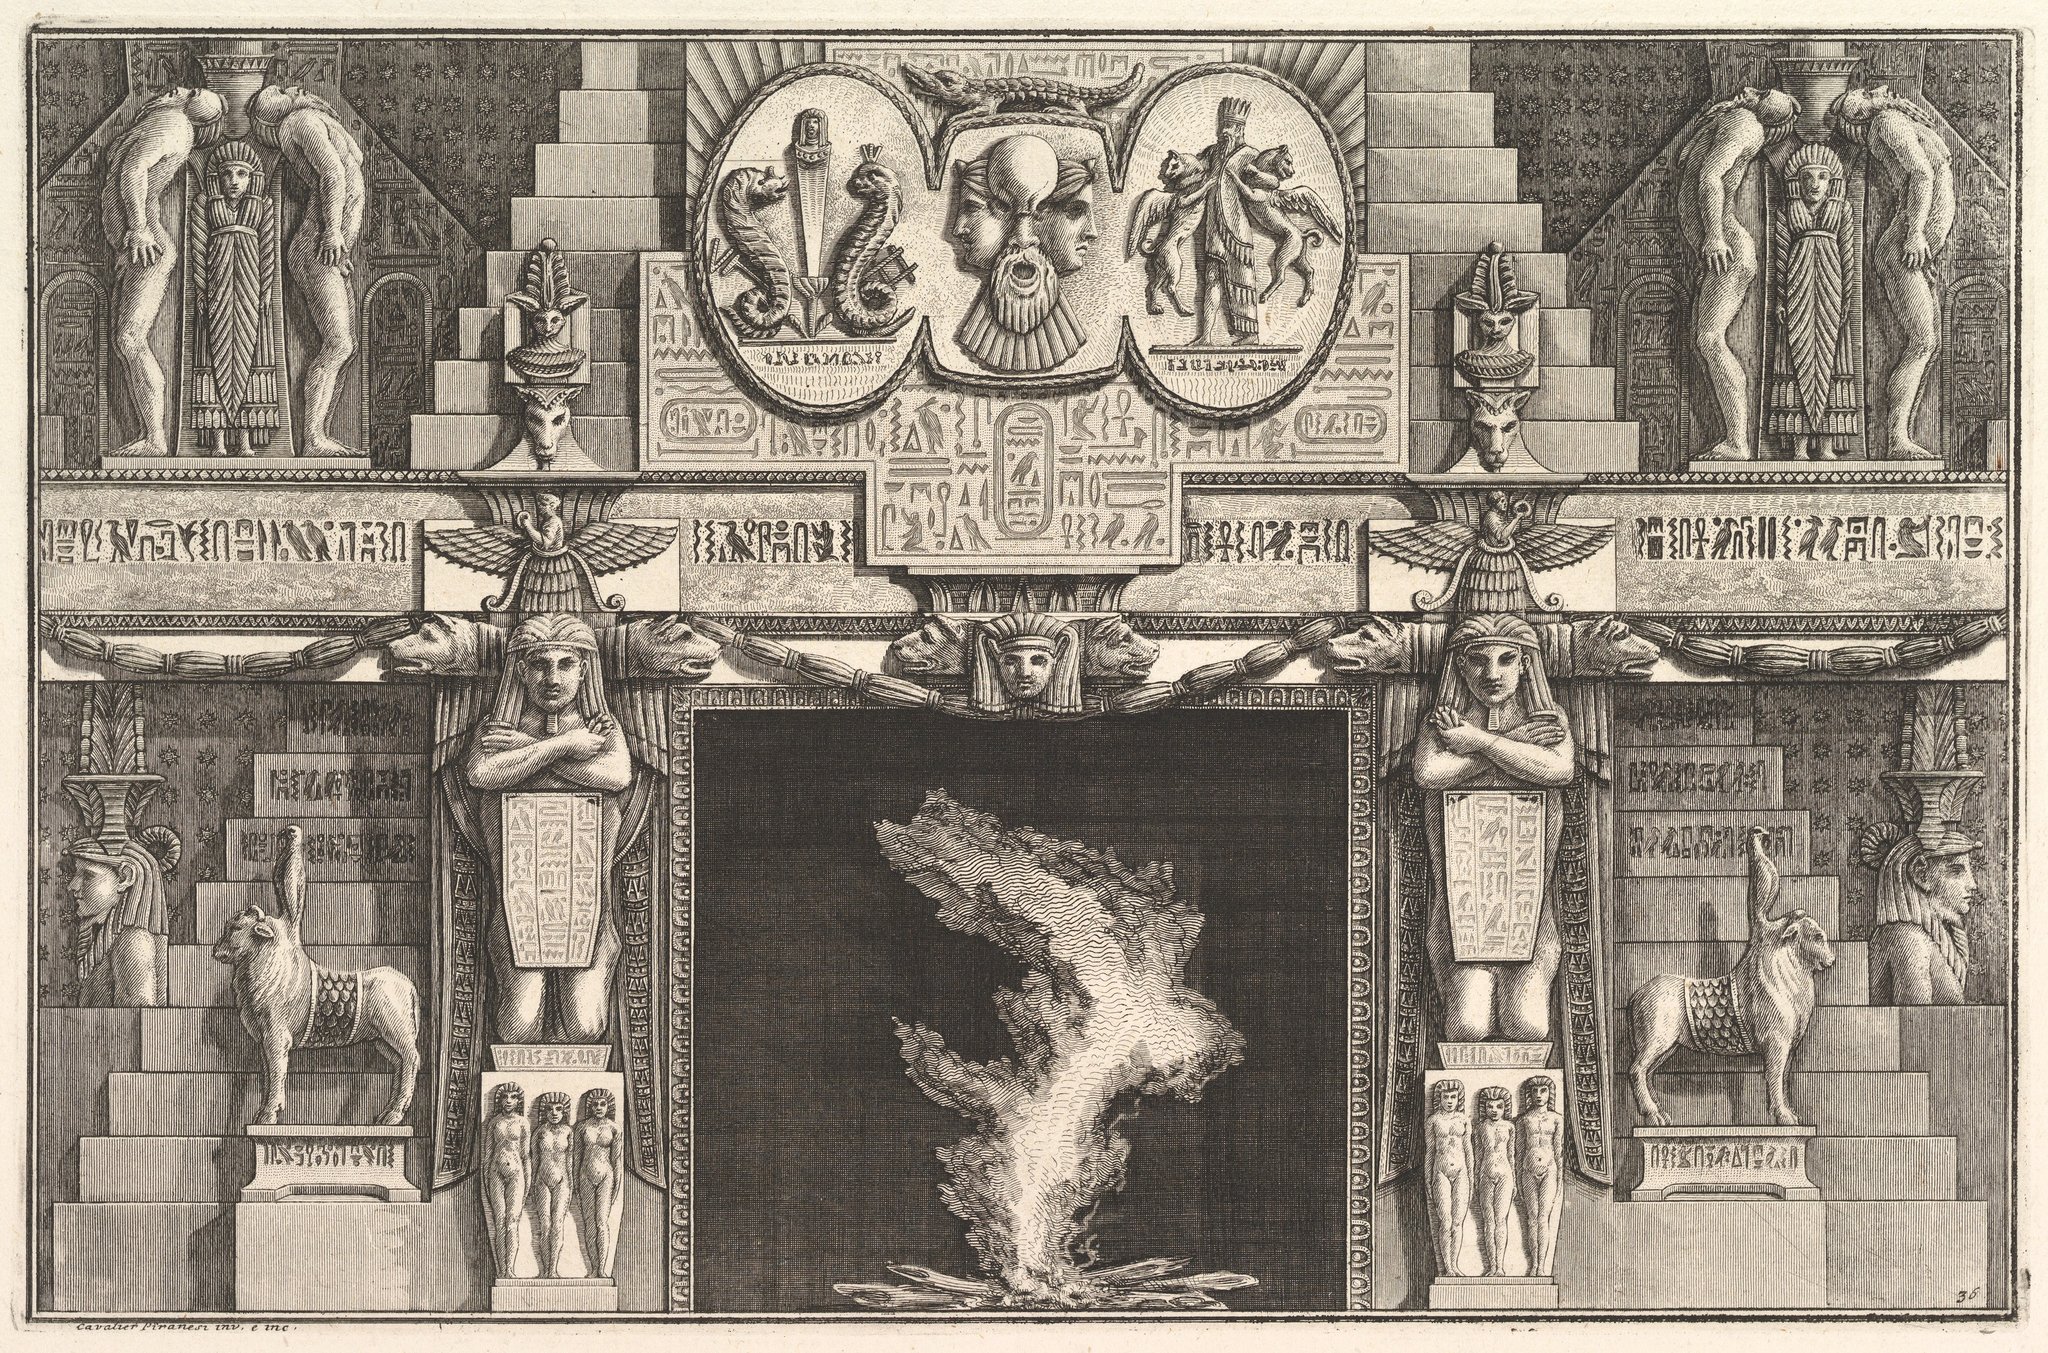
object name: print ornament architecture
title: Chimneypiece in the Egyptian style: Groups of three female nudes at the base of each jamb, surmounted by larger kneeling figures), from Diverse Maniere d'adornare i cammini ed ogni altra parte degli edifizi...(Different Ways of ornamenting chimneypieces and all other parts of houses)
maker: giovanni battista piranesi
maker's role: artist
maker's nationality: italian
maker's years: 1720-1778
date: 1769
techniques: etching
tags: female nudes,hieroglyphs,fire